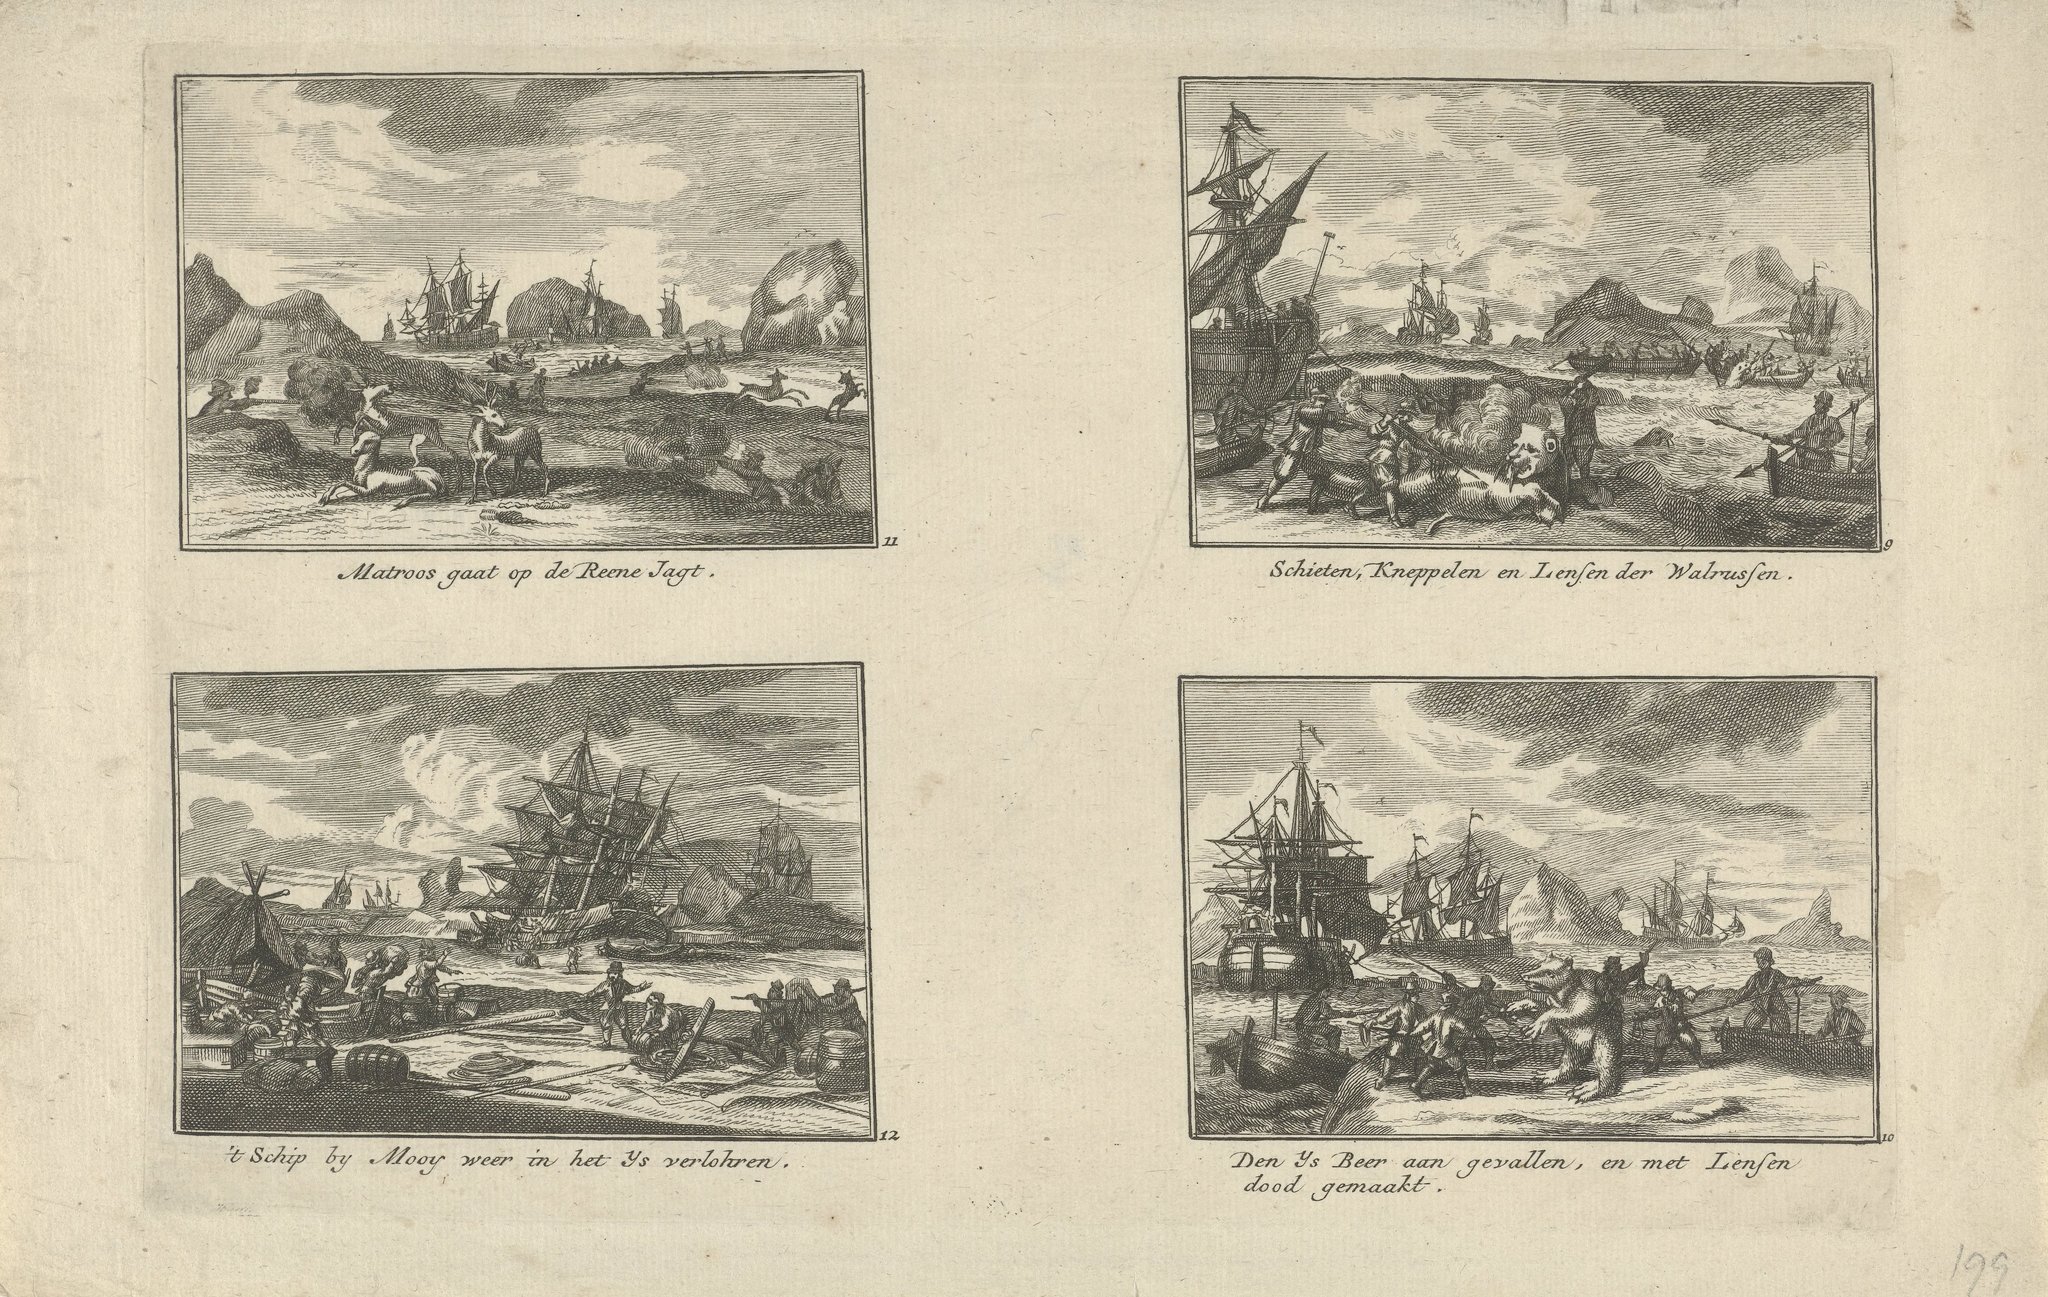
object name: print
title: Jacht in de ijszee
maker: Anonymous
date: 1720-1750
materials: paper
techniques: etching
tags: hunting, chase, shipwreck, whale fishery, whaling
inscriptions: collector's mark: Lugt 2228